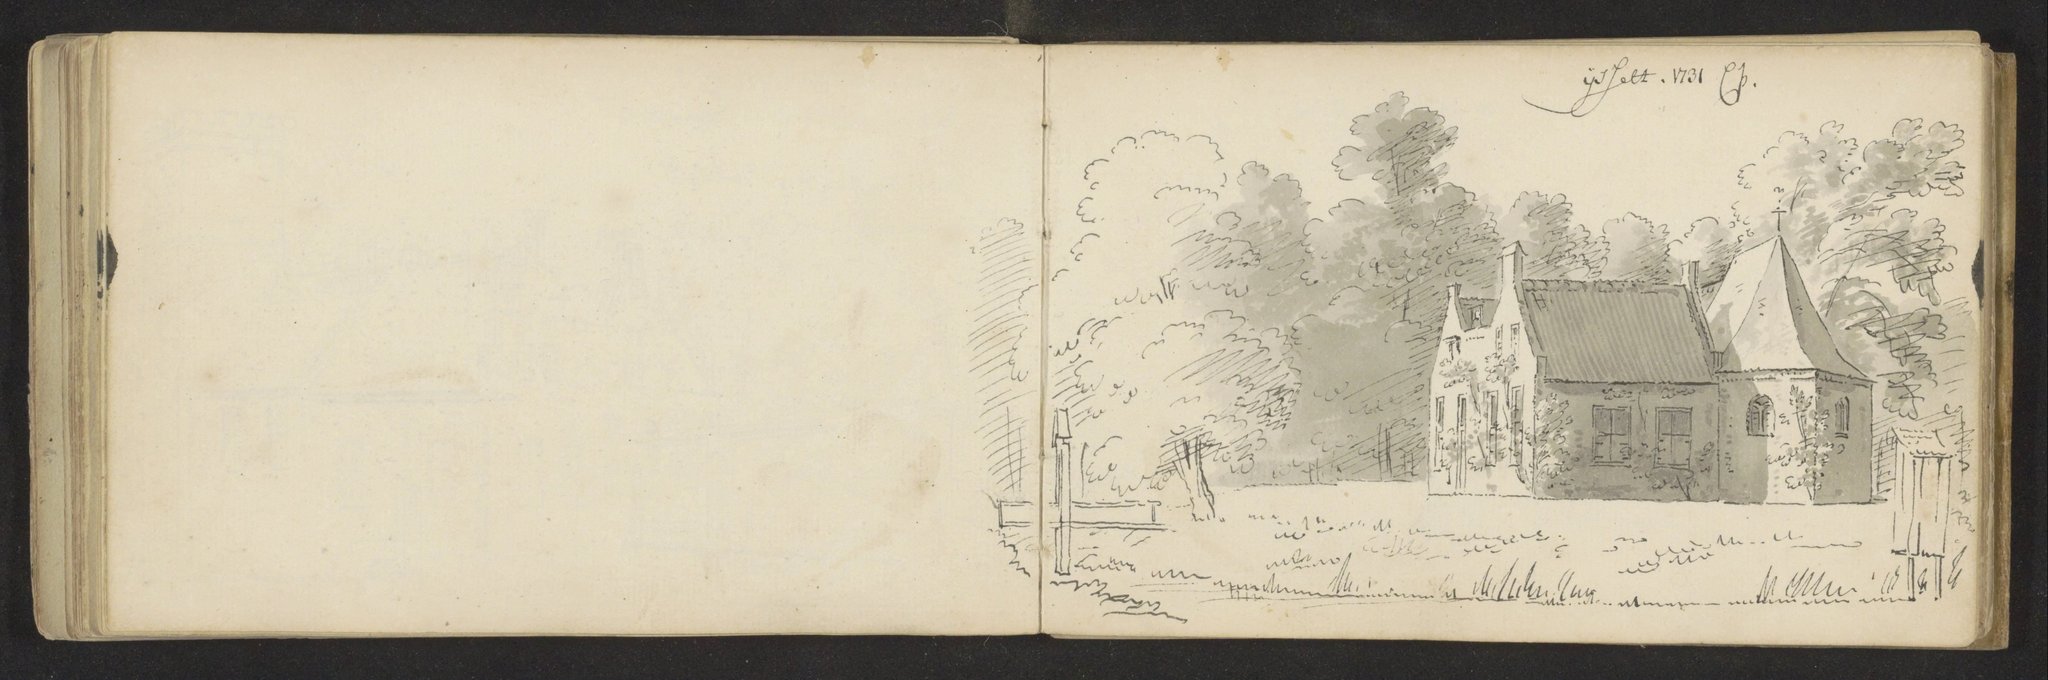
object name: sketchbook leaf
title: Kapel van Huis Isselt op de grens van Soest en Amersfoort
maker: abraham de haen (ii)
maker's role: draughtsman, print maker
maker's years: 1707-1748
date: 1731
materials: ink, paper, pencil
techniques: brush, pen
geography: soest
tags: church (exterior)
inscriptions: date and inscription: ‘IJsselt. 1731 CP.’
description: Blad 48 verso en 49 recto uit een schetsboek met 78 bladen.